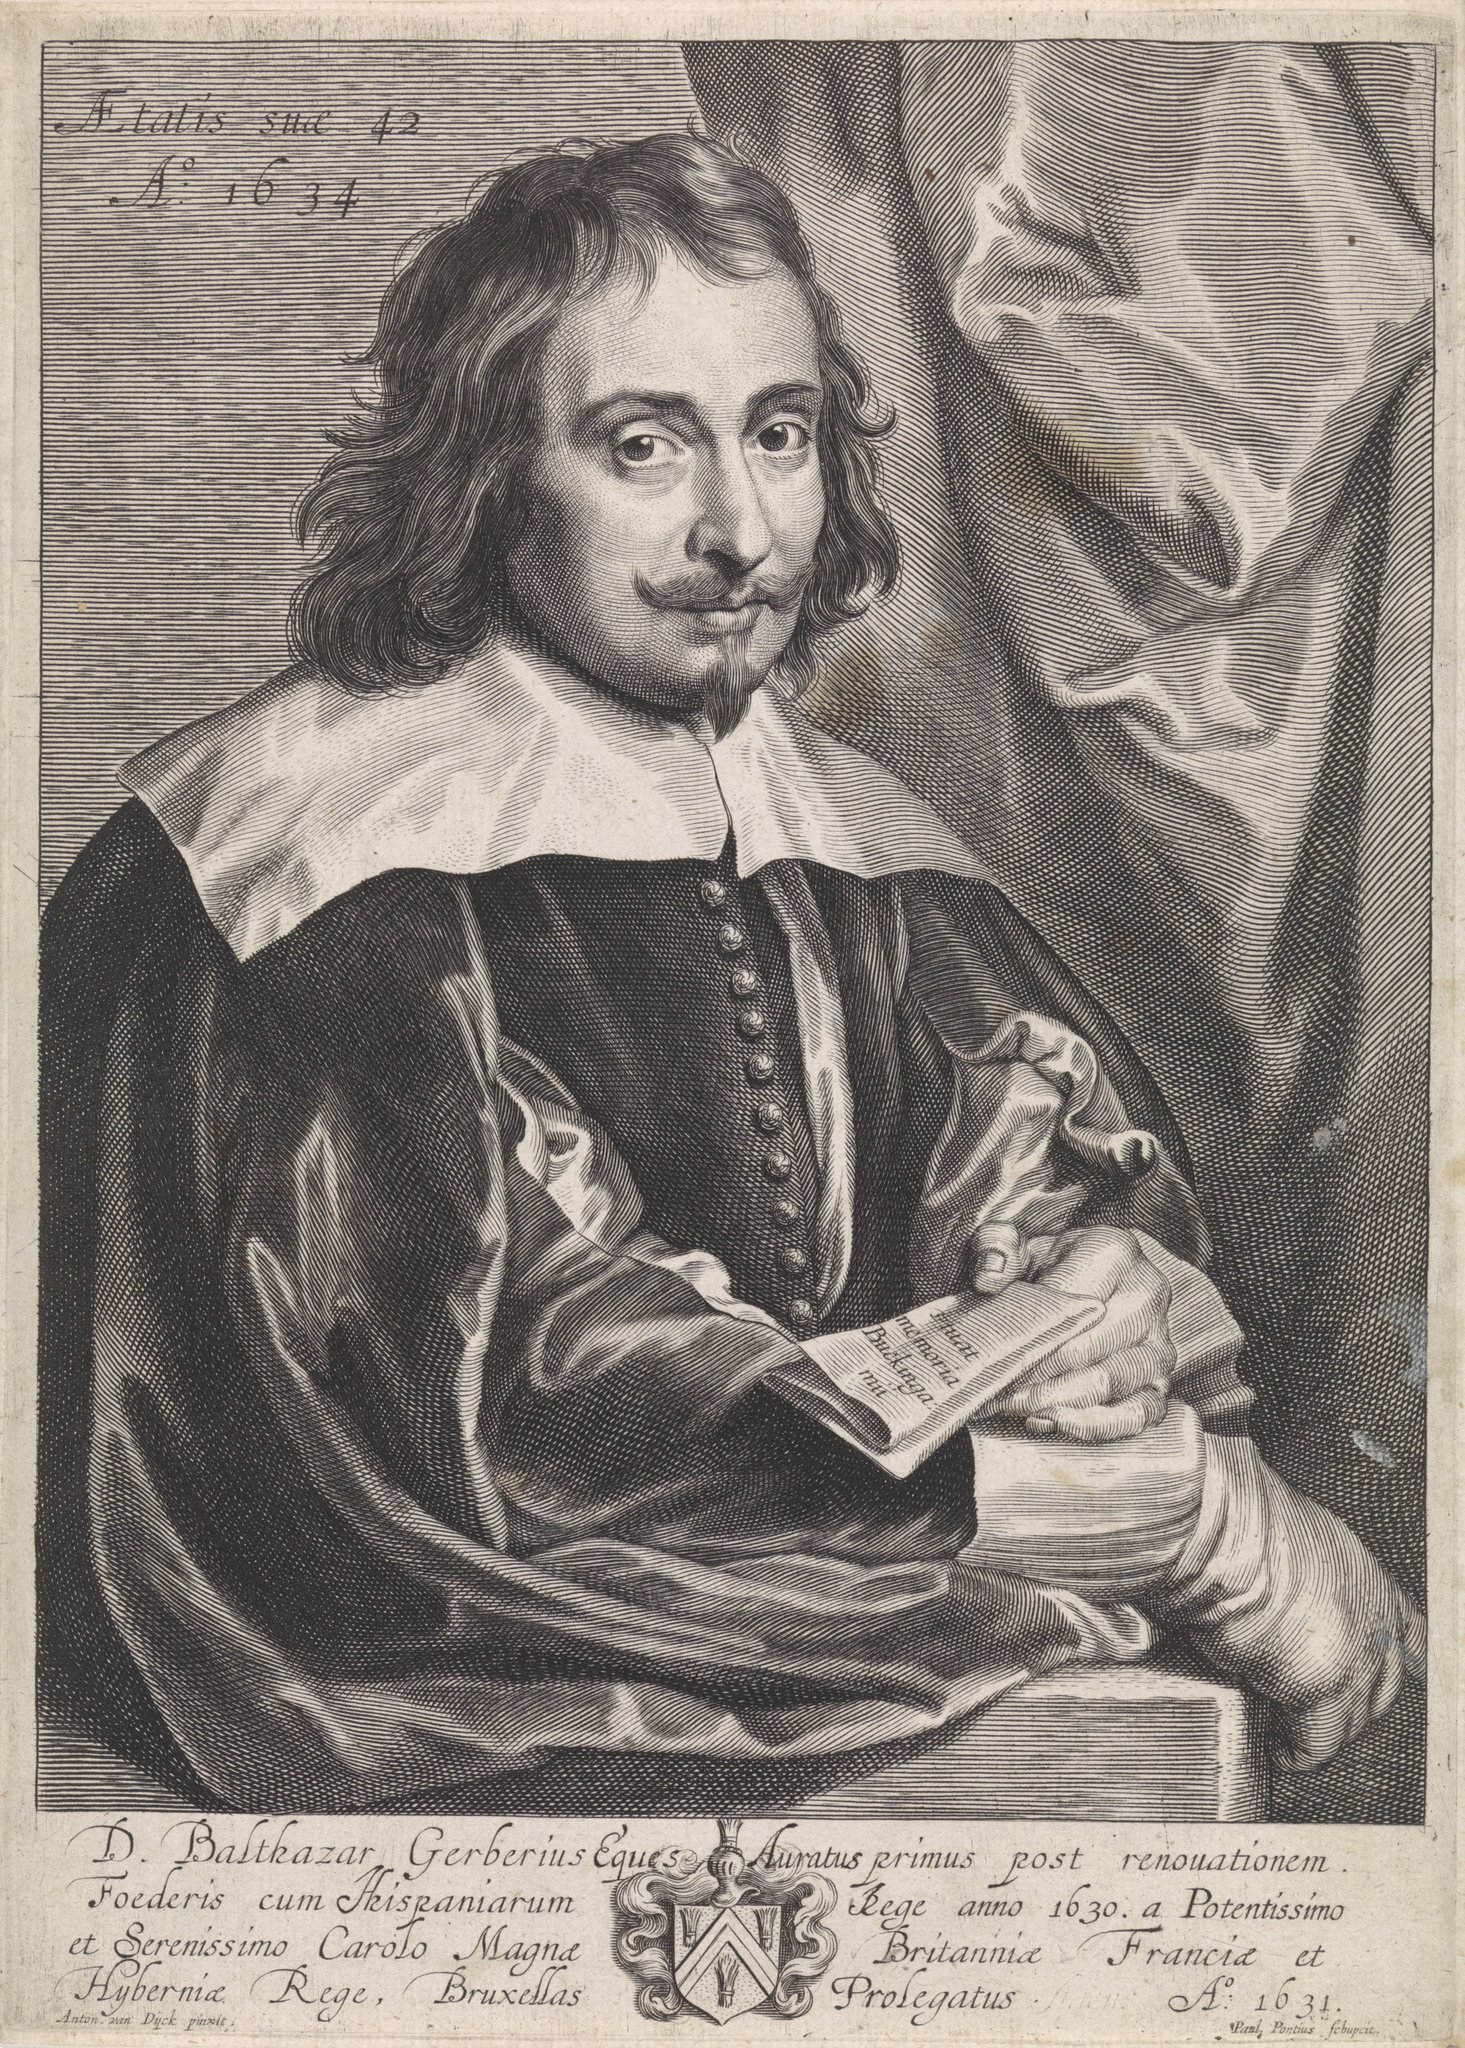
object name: print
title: Portret van Balthasar Gerbier, op 42-jarige leeftijd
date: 1634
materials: paper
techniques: engraving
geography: antwerp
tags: draughtsman, balthazar gerbier d'ouvilly, letter, envelope, armorial bearing, heraldry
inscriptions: collector's mark: Lugt 2228